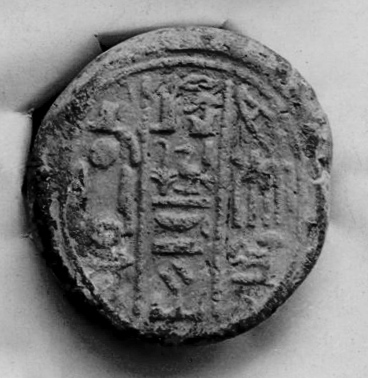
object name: cone, circular stamp, merymose, king's son, kush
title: Funerary Cone of the King's Son of Kush Merymose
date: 1550-1295 BCE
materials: pottery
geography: egypt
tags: hieroglyphs